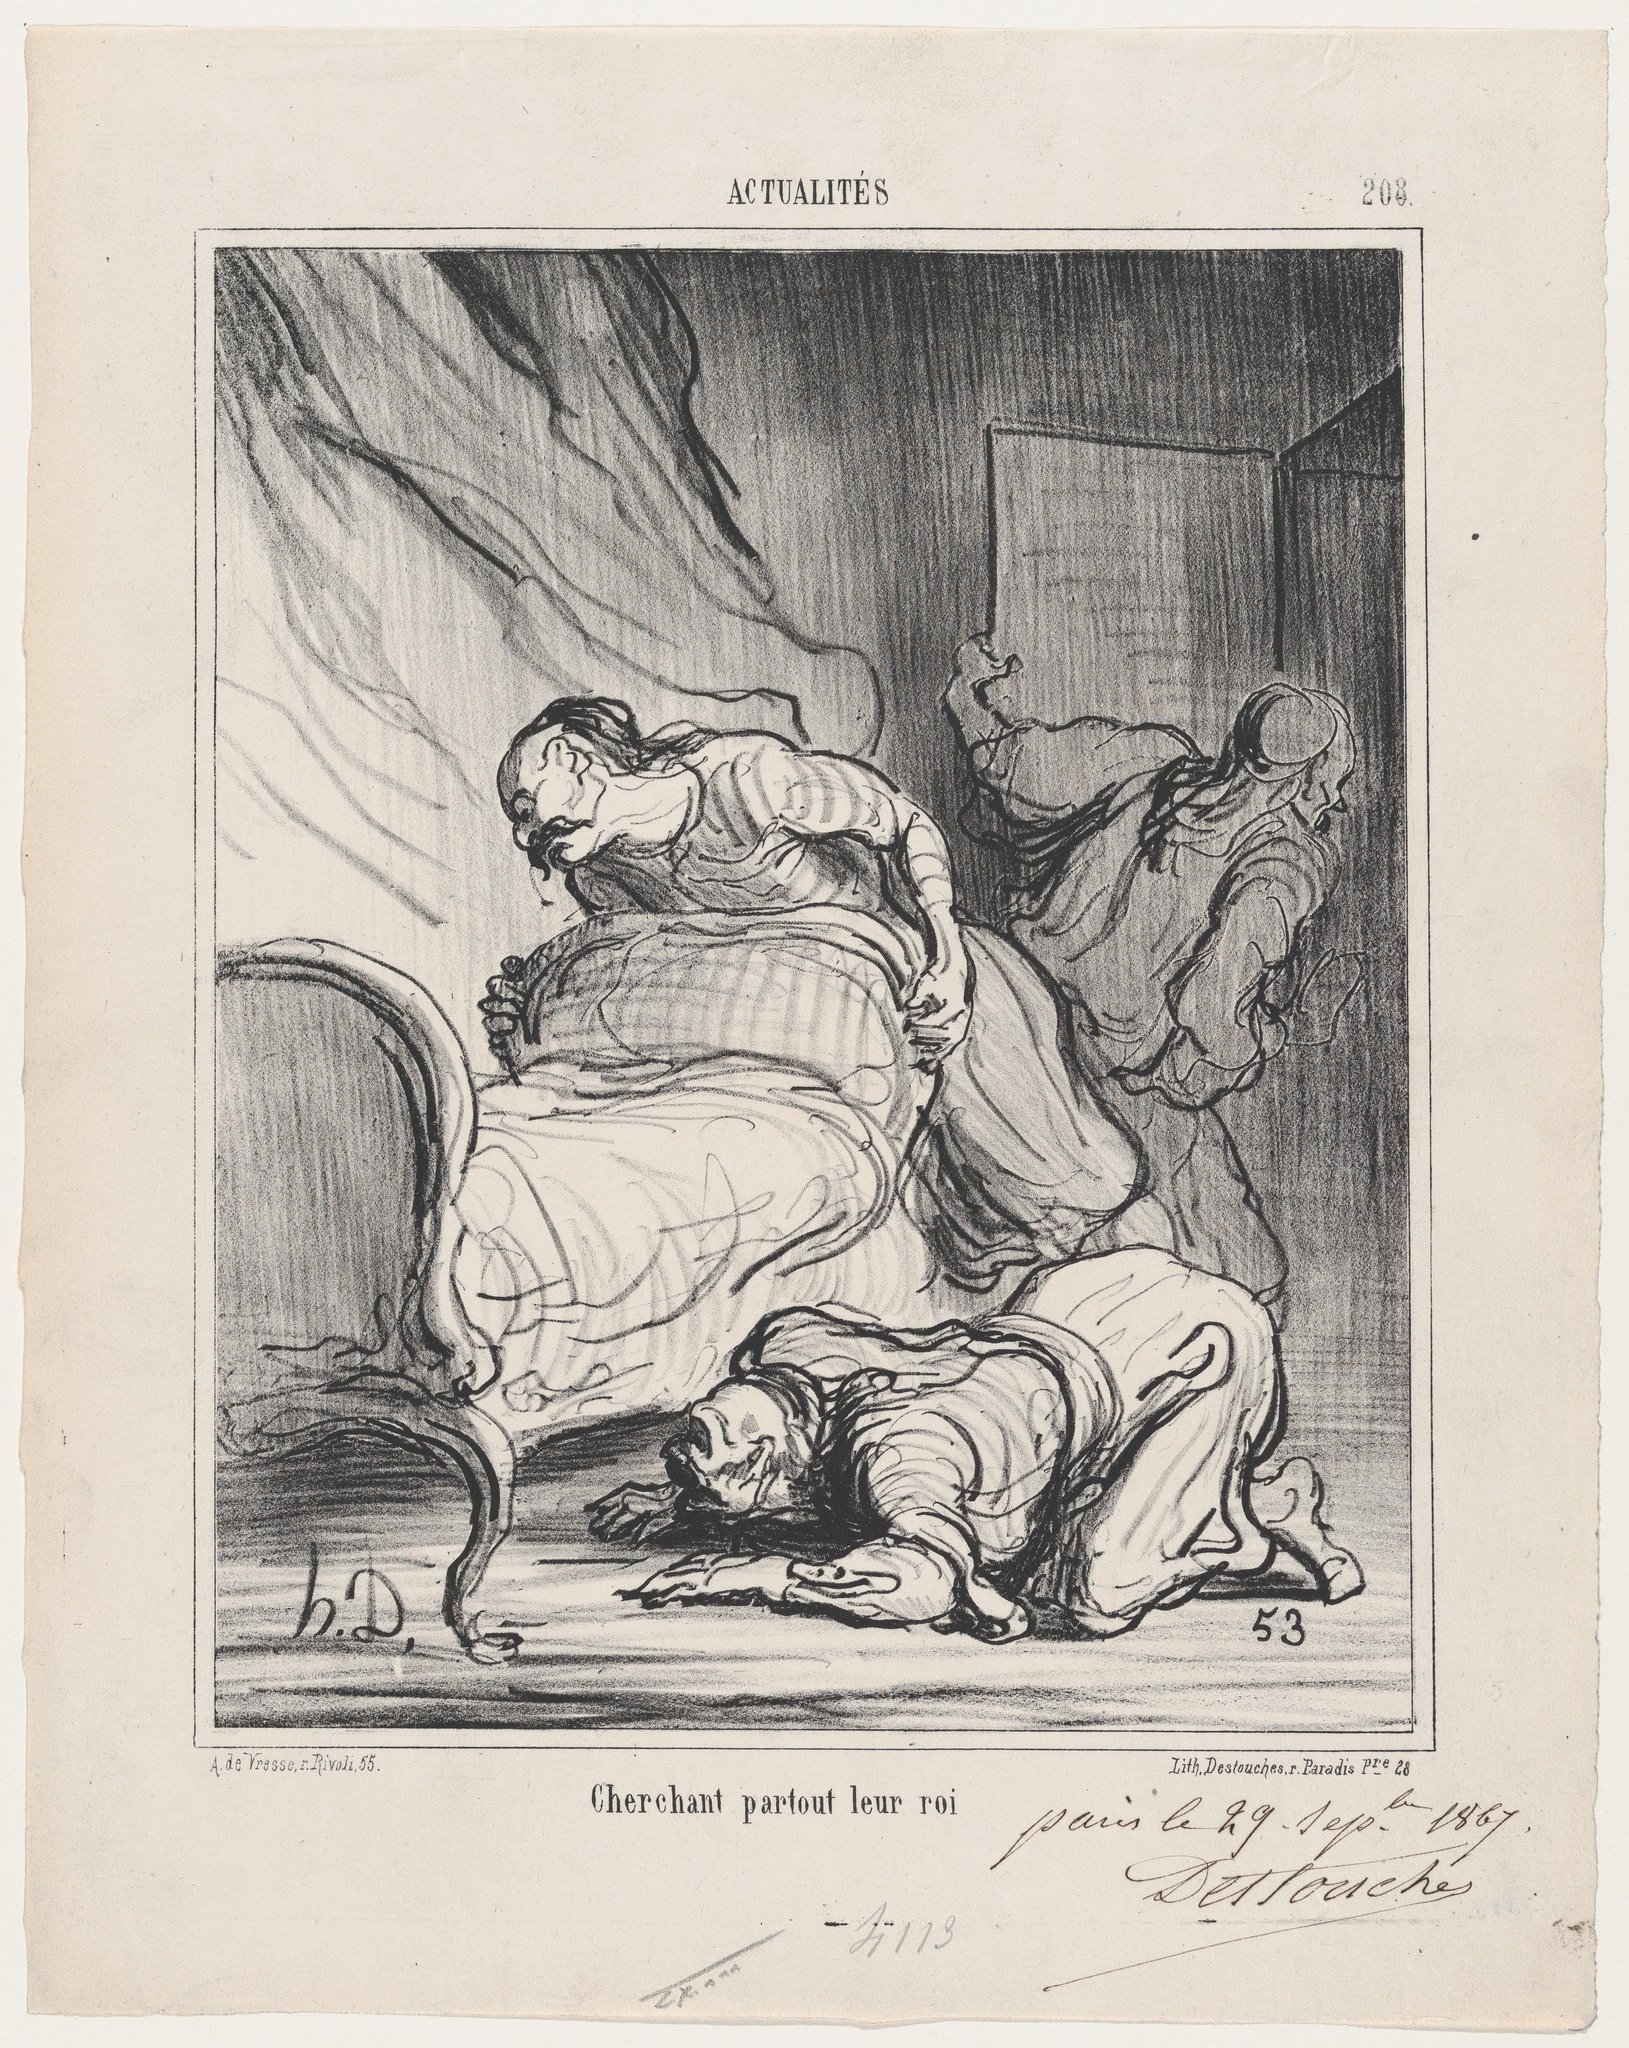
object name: print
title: Looking everywhere for their king, from 'News of the day,' published in Le Charivari, October 4, 1867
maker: honoré daumier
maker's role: artist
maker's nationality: french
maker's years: 1808-1879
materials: ink, paper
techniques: lithograph, pen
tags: men